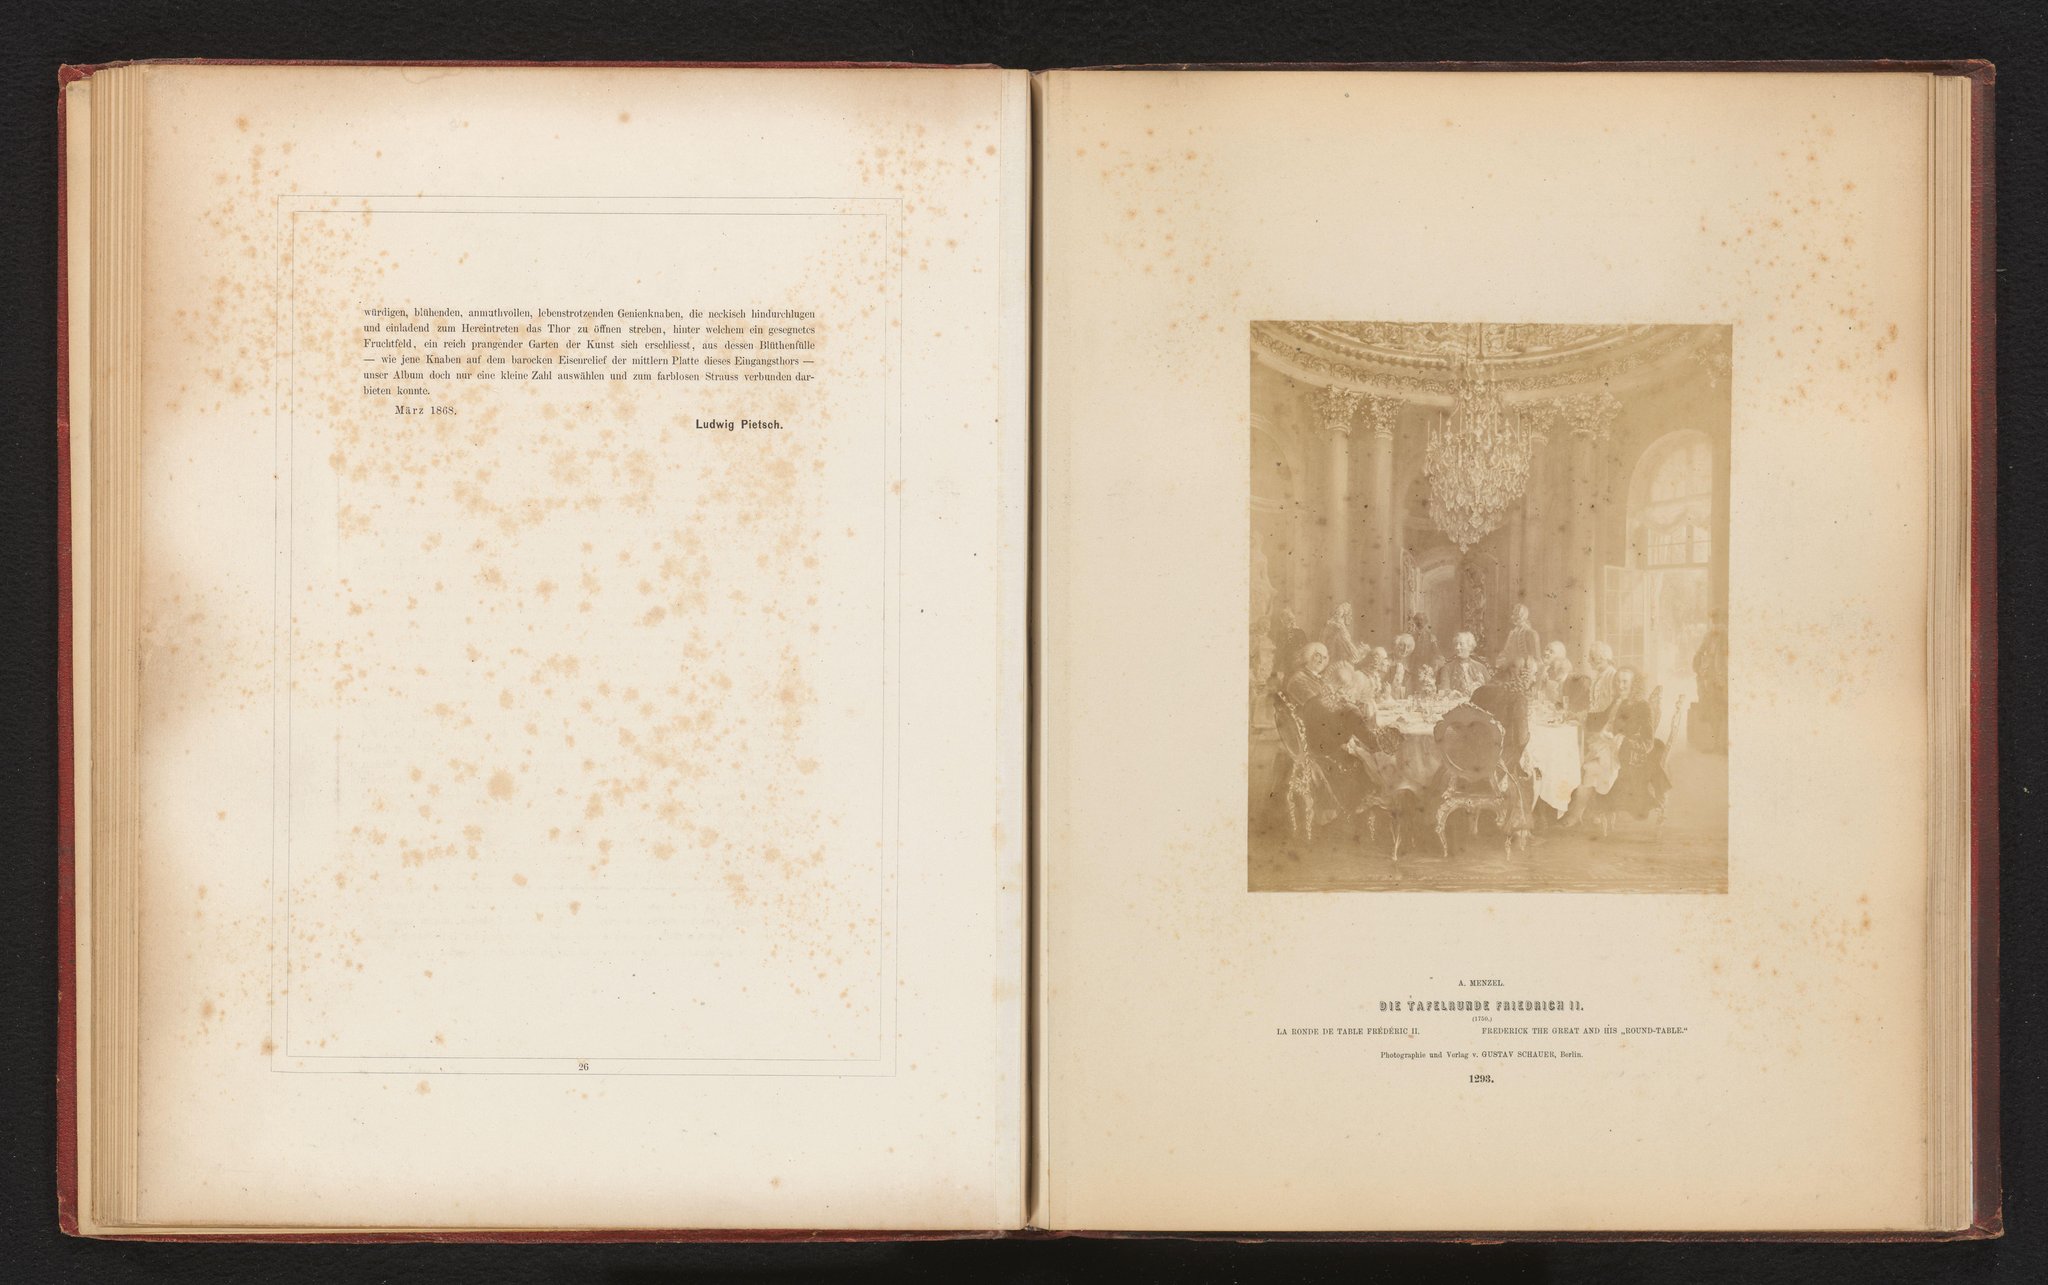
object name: photograph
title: Die Tafelrunde Friedrich II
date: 1863-1868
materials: paper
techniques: albumen print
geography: berlin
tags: frederick ii (king of prussia), evening meal, dinner, supper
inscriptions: number: ‘1293.’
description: Foto op eerste ongenummerde pagina na pagina 26.